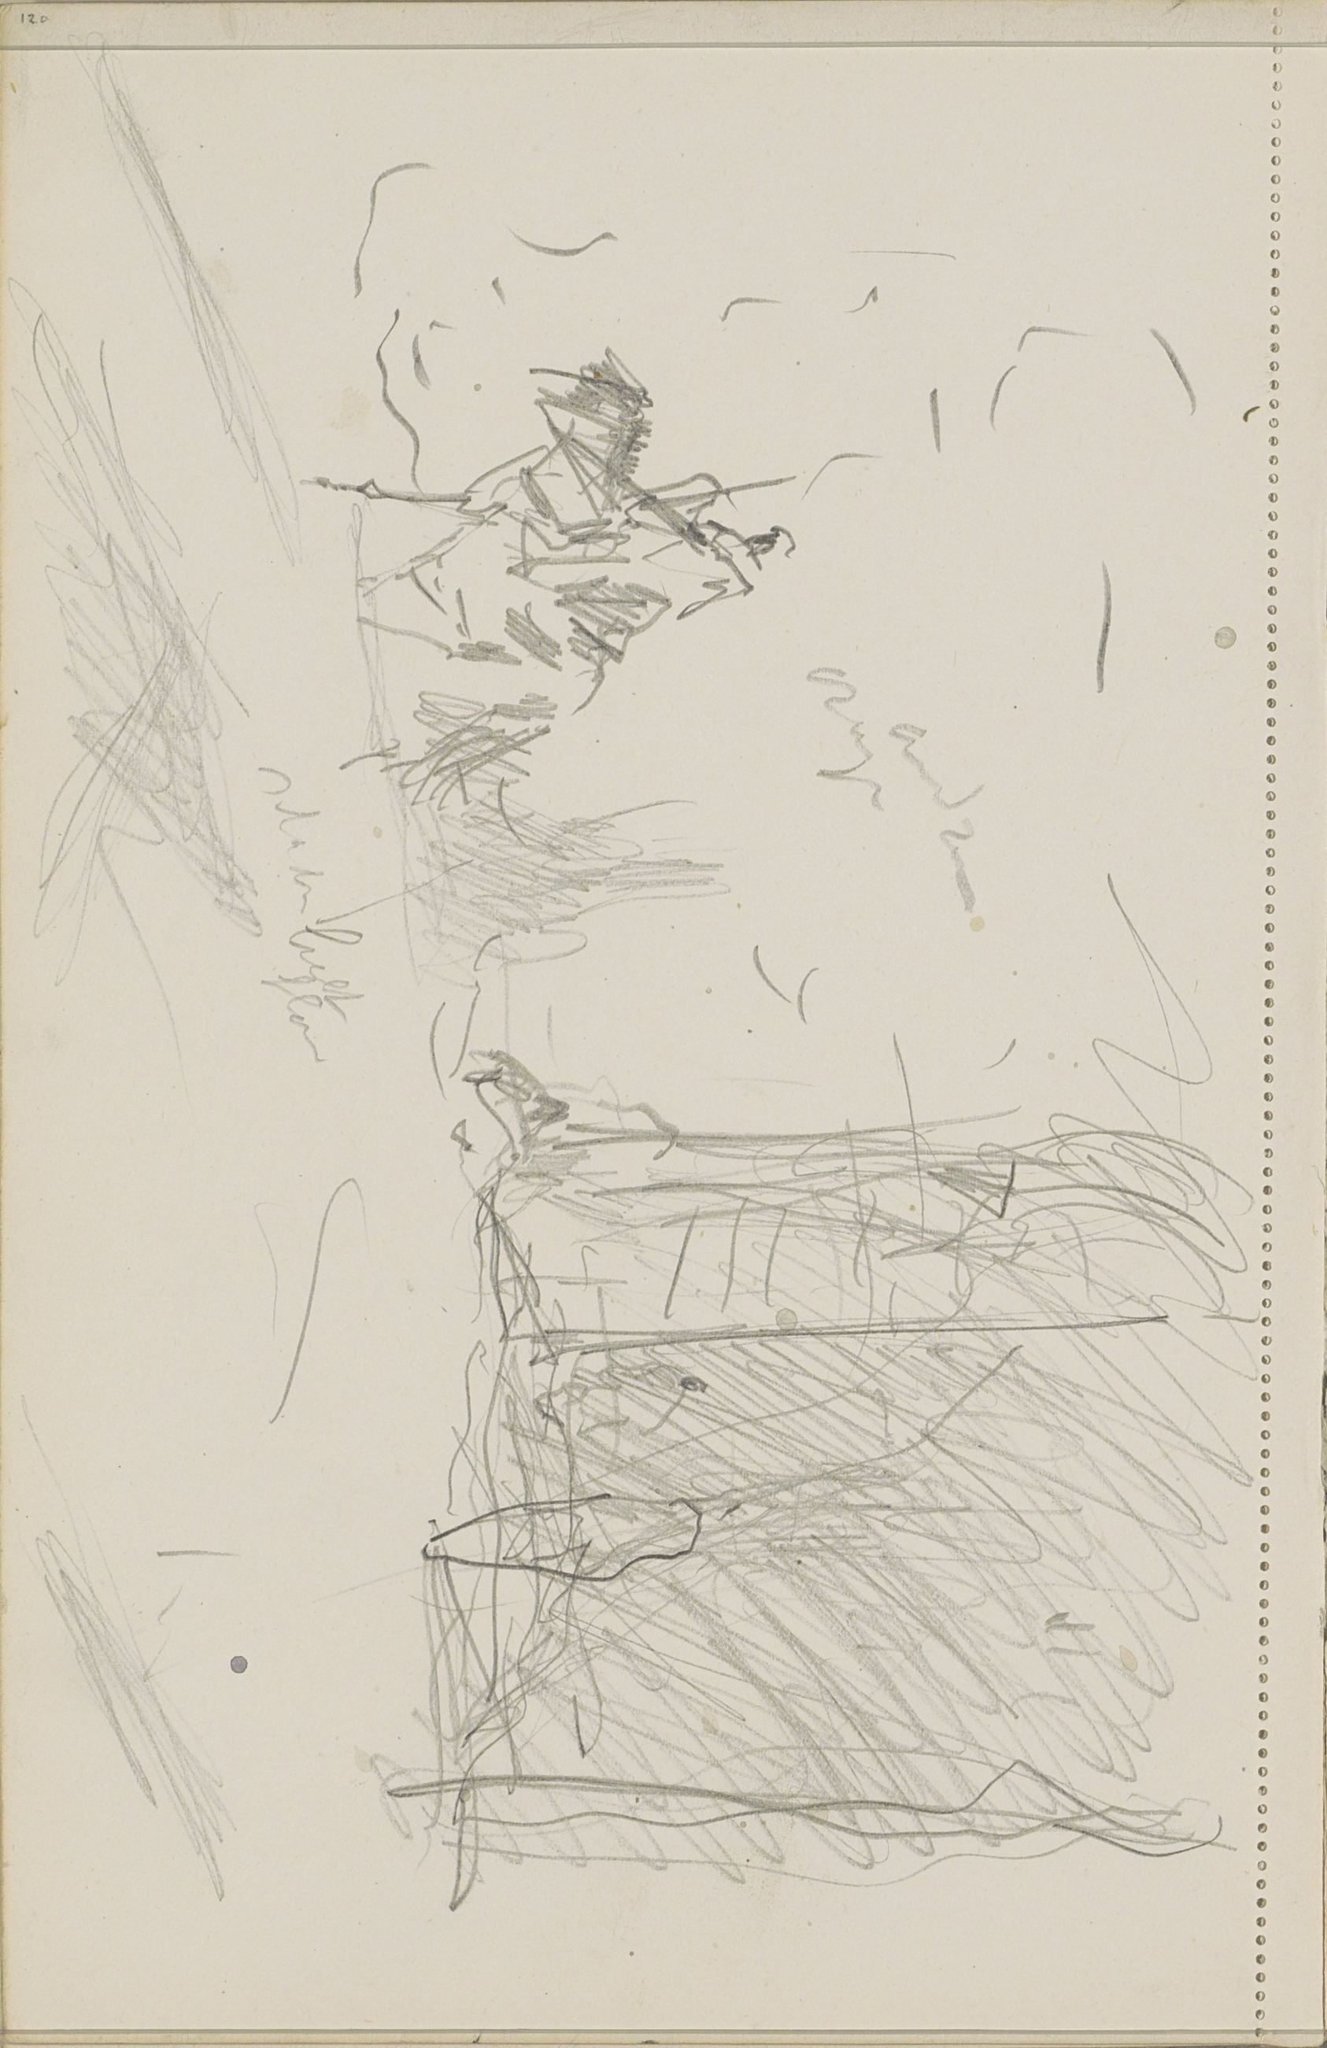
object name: sketchbook leaf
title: Ruiters en figuren bij een muur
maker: marius bauer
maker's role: draughtsman, print maker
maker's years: 1867-1932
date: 1923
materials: paper, pencil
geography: morocco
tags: riding a horse, ass, or mule; rider, horseman, street (+ city(-scape) with figures, staffage)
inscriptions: kleurnotitie, handgeschreven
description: De aquarel 'Marokkaanse ruiters voor de stadspoort' uit 1925 is gebaseerd op deze schets (zie documentatie).